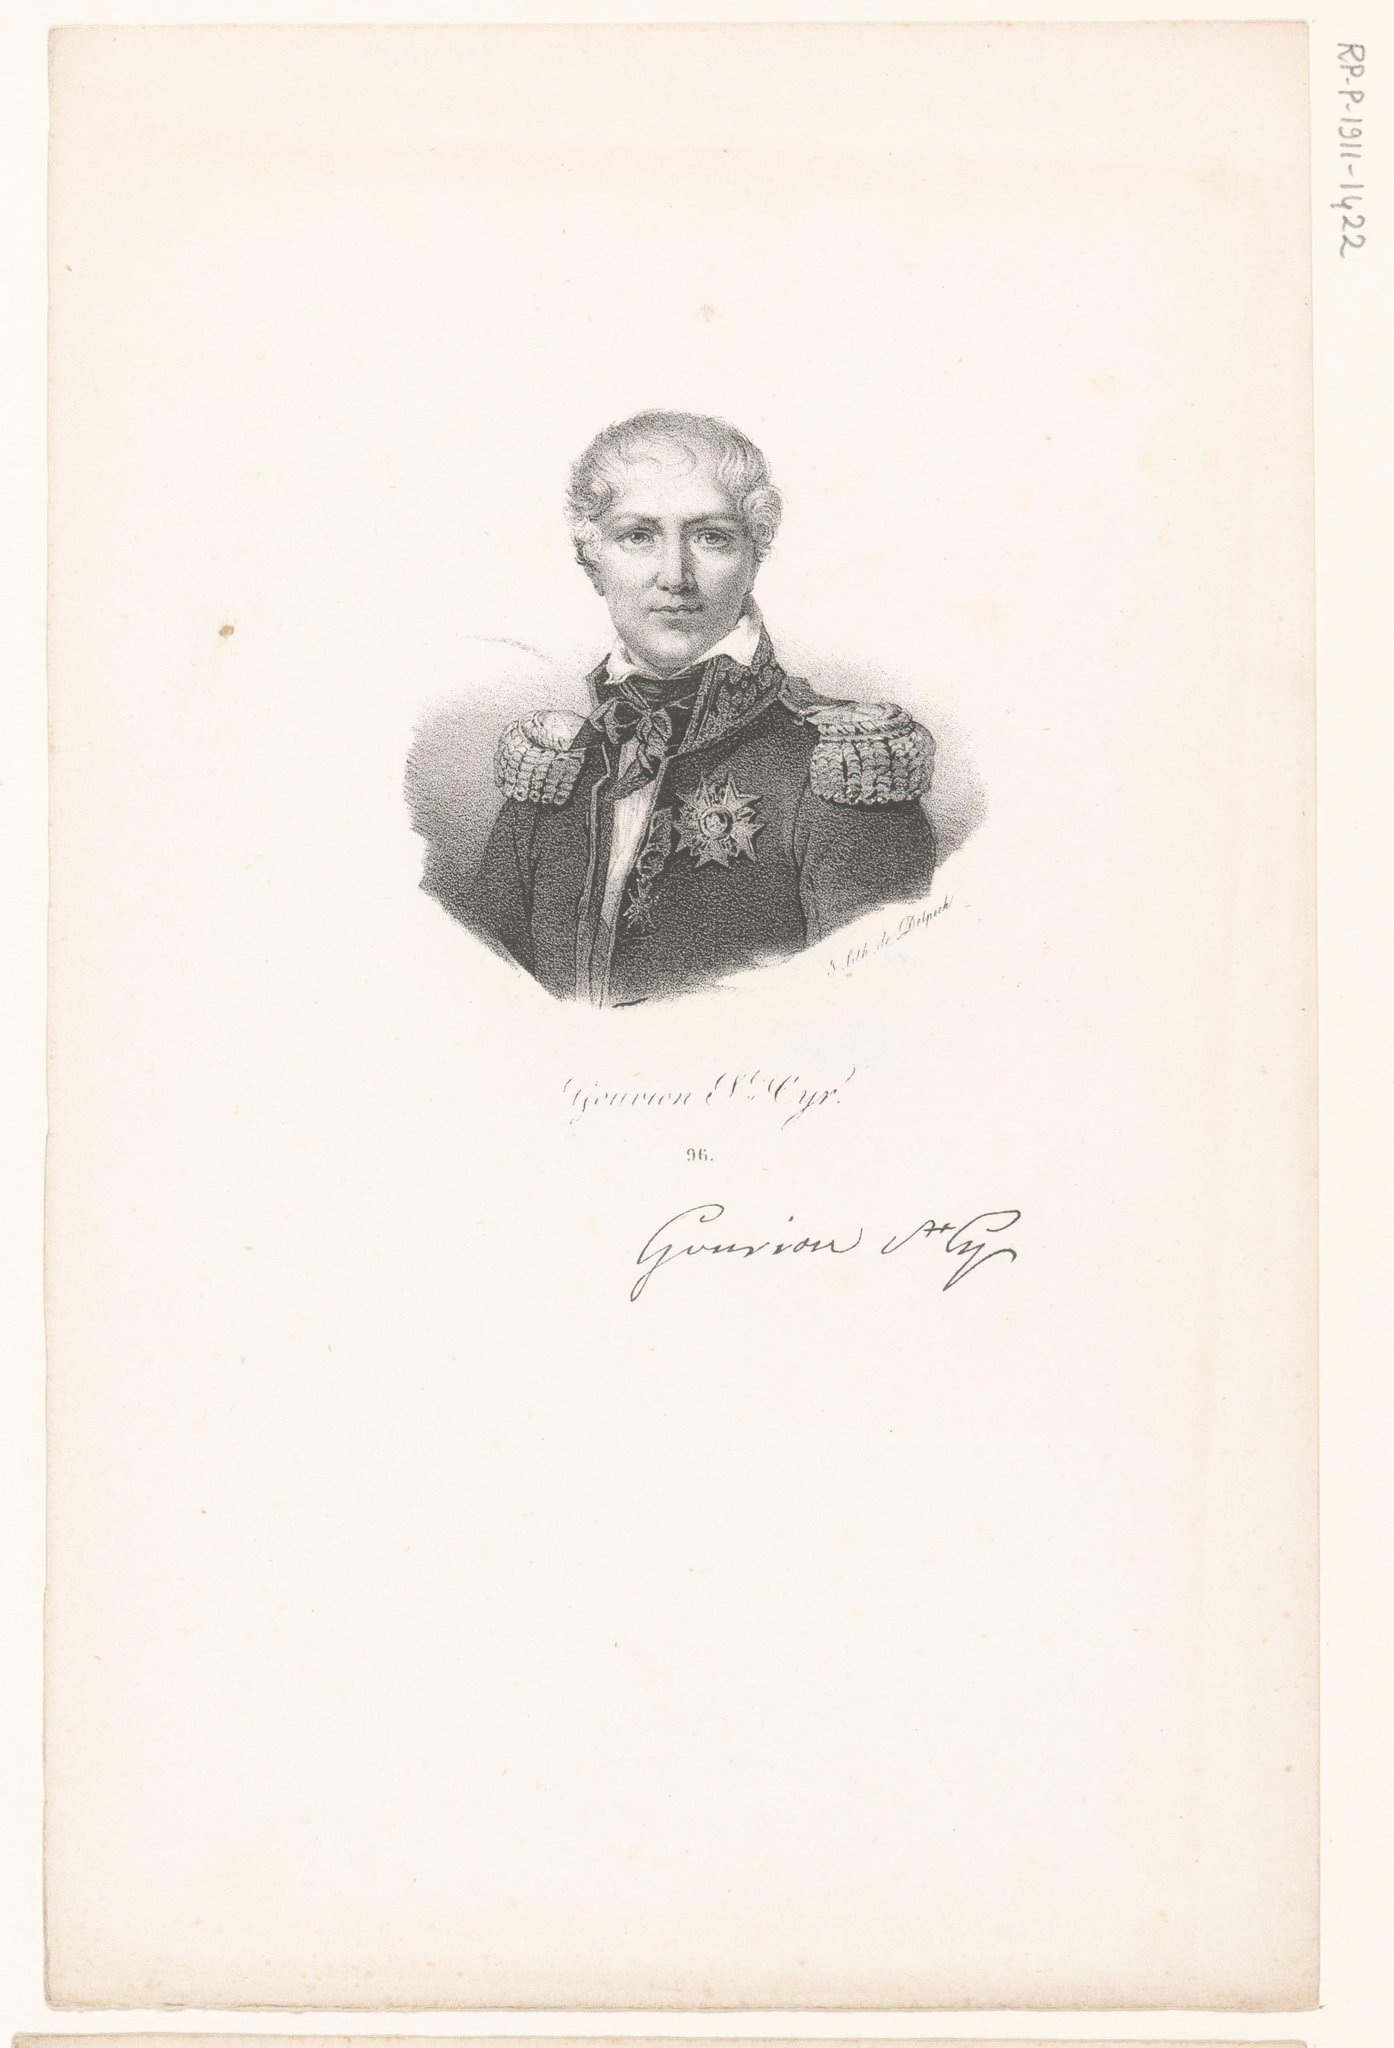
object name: print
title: Portret van Laurent de Gouvion-Saint-Cyr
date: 1818-1842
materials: paper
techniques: lithograph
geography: paris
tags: historical persons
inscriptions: collector's mark: Lugt 2228a